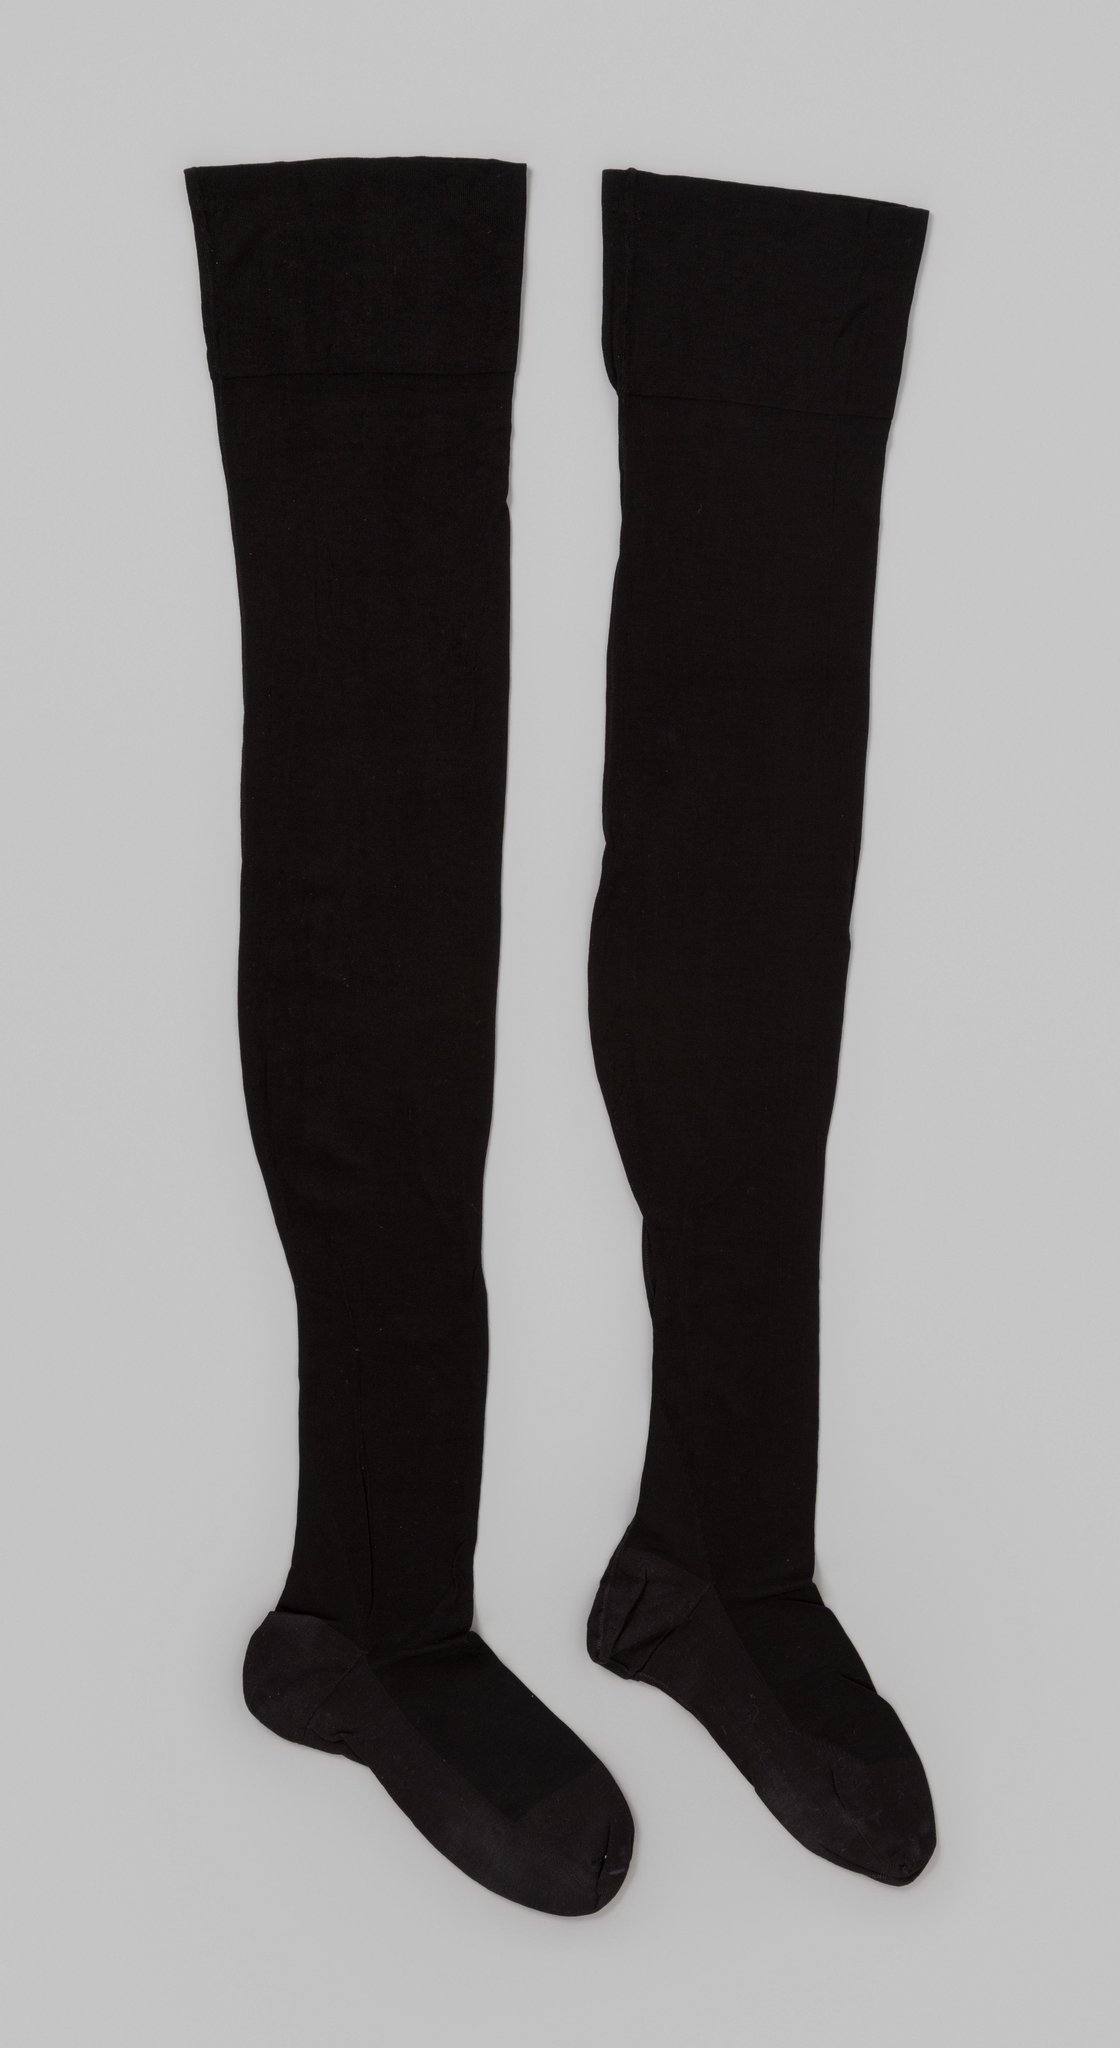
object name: clothing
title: Kous van effen zwarte zijde tricot met brede boord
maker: Anonymous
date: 1915-1935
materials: silk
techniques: knitting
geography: netherlands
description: Vijf paar zwarte kousen van zijde. Alle verschillend, alle van dikke tricot. Alle met naad en hiel. Brede verschillende boorden; enkele van katoen. Eén paar heeft een enkel-pijl, de klink.